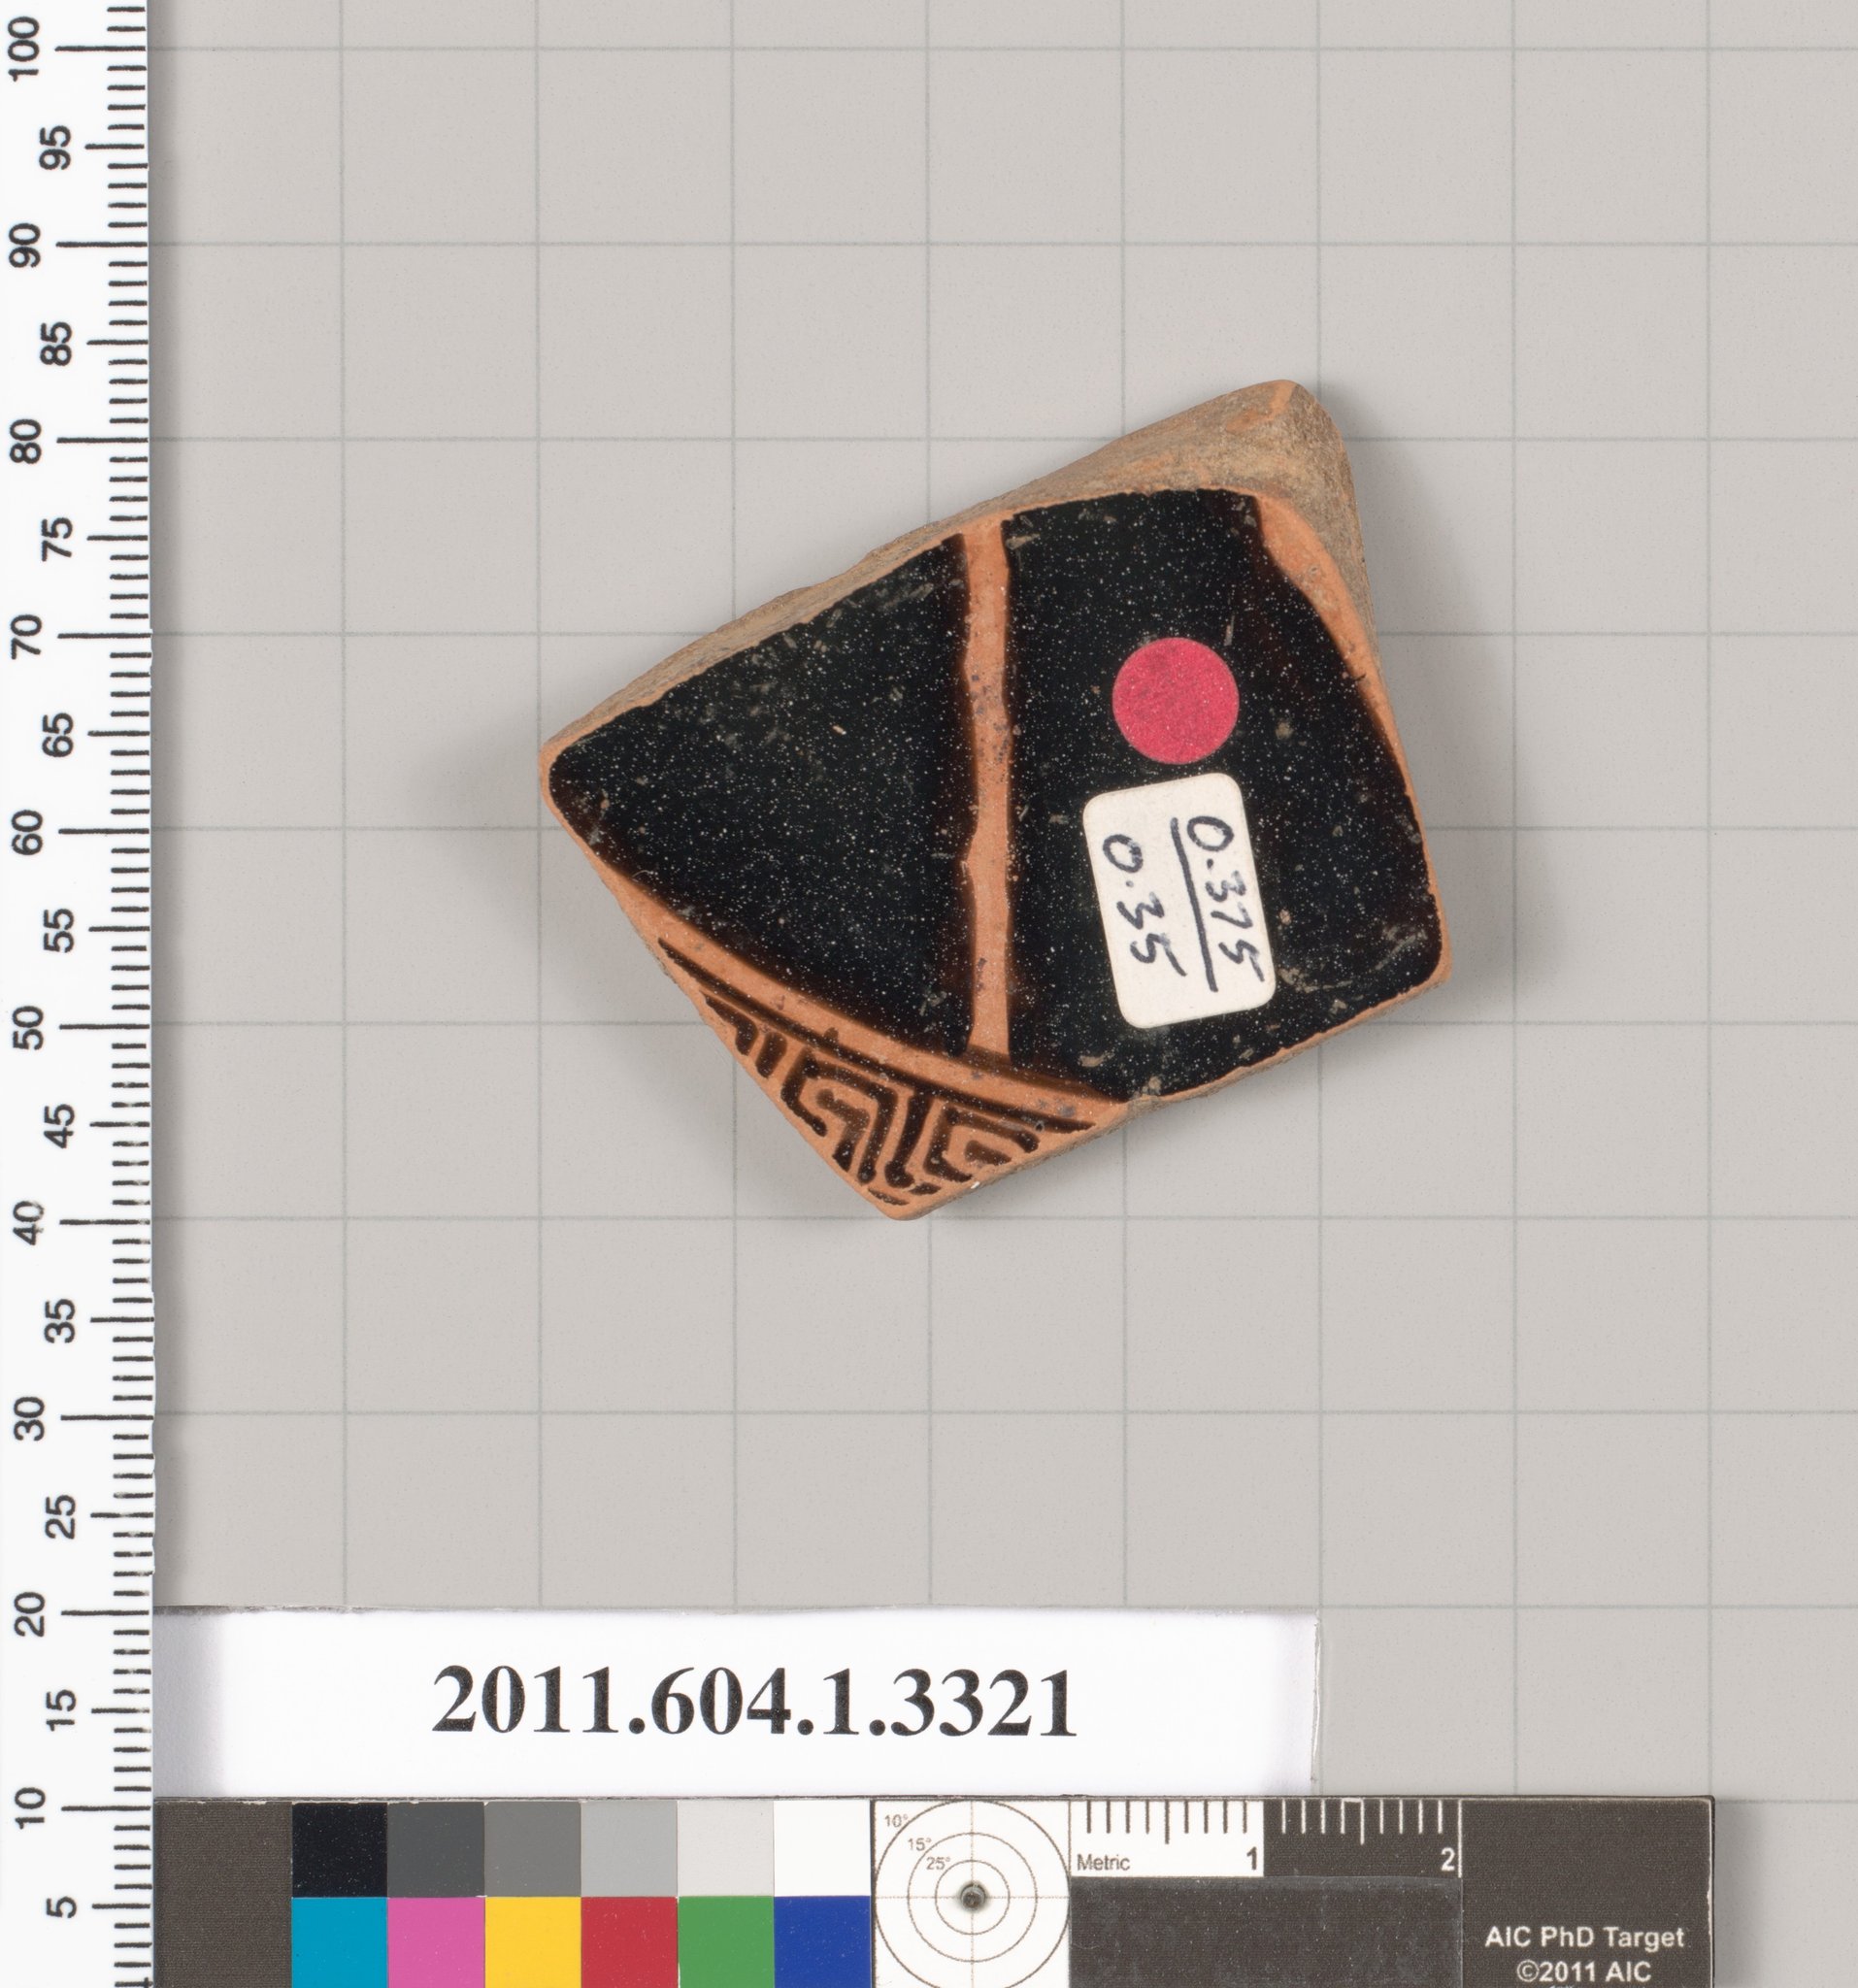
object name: kylix fragment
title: Terracotta fragment of a kylix (drinking cup)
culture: greek, attic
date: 500-470 BCE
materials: terracotta